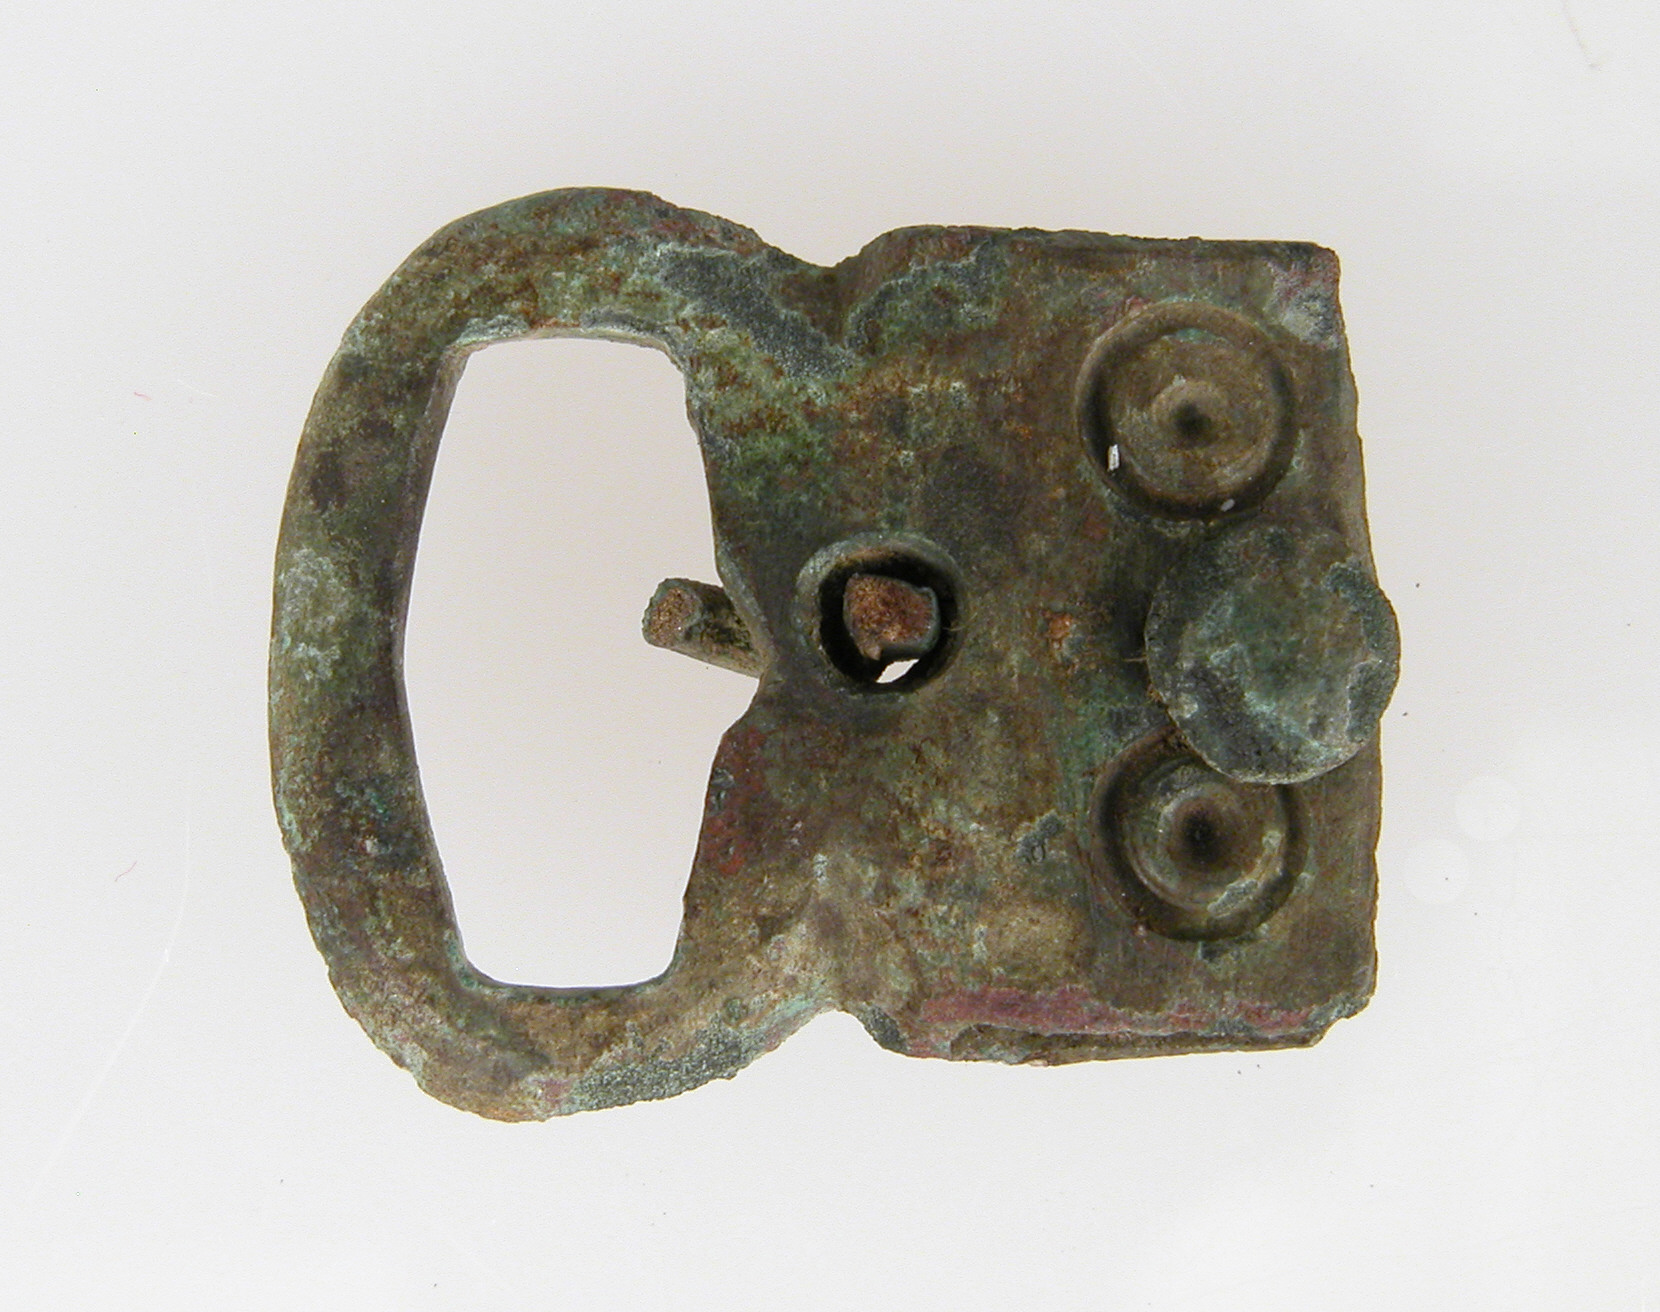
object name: buckle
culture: frankish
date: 501-700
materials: copper alloy